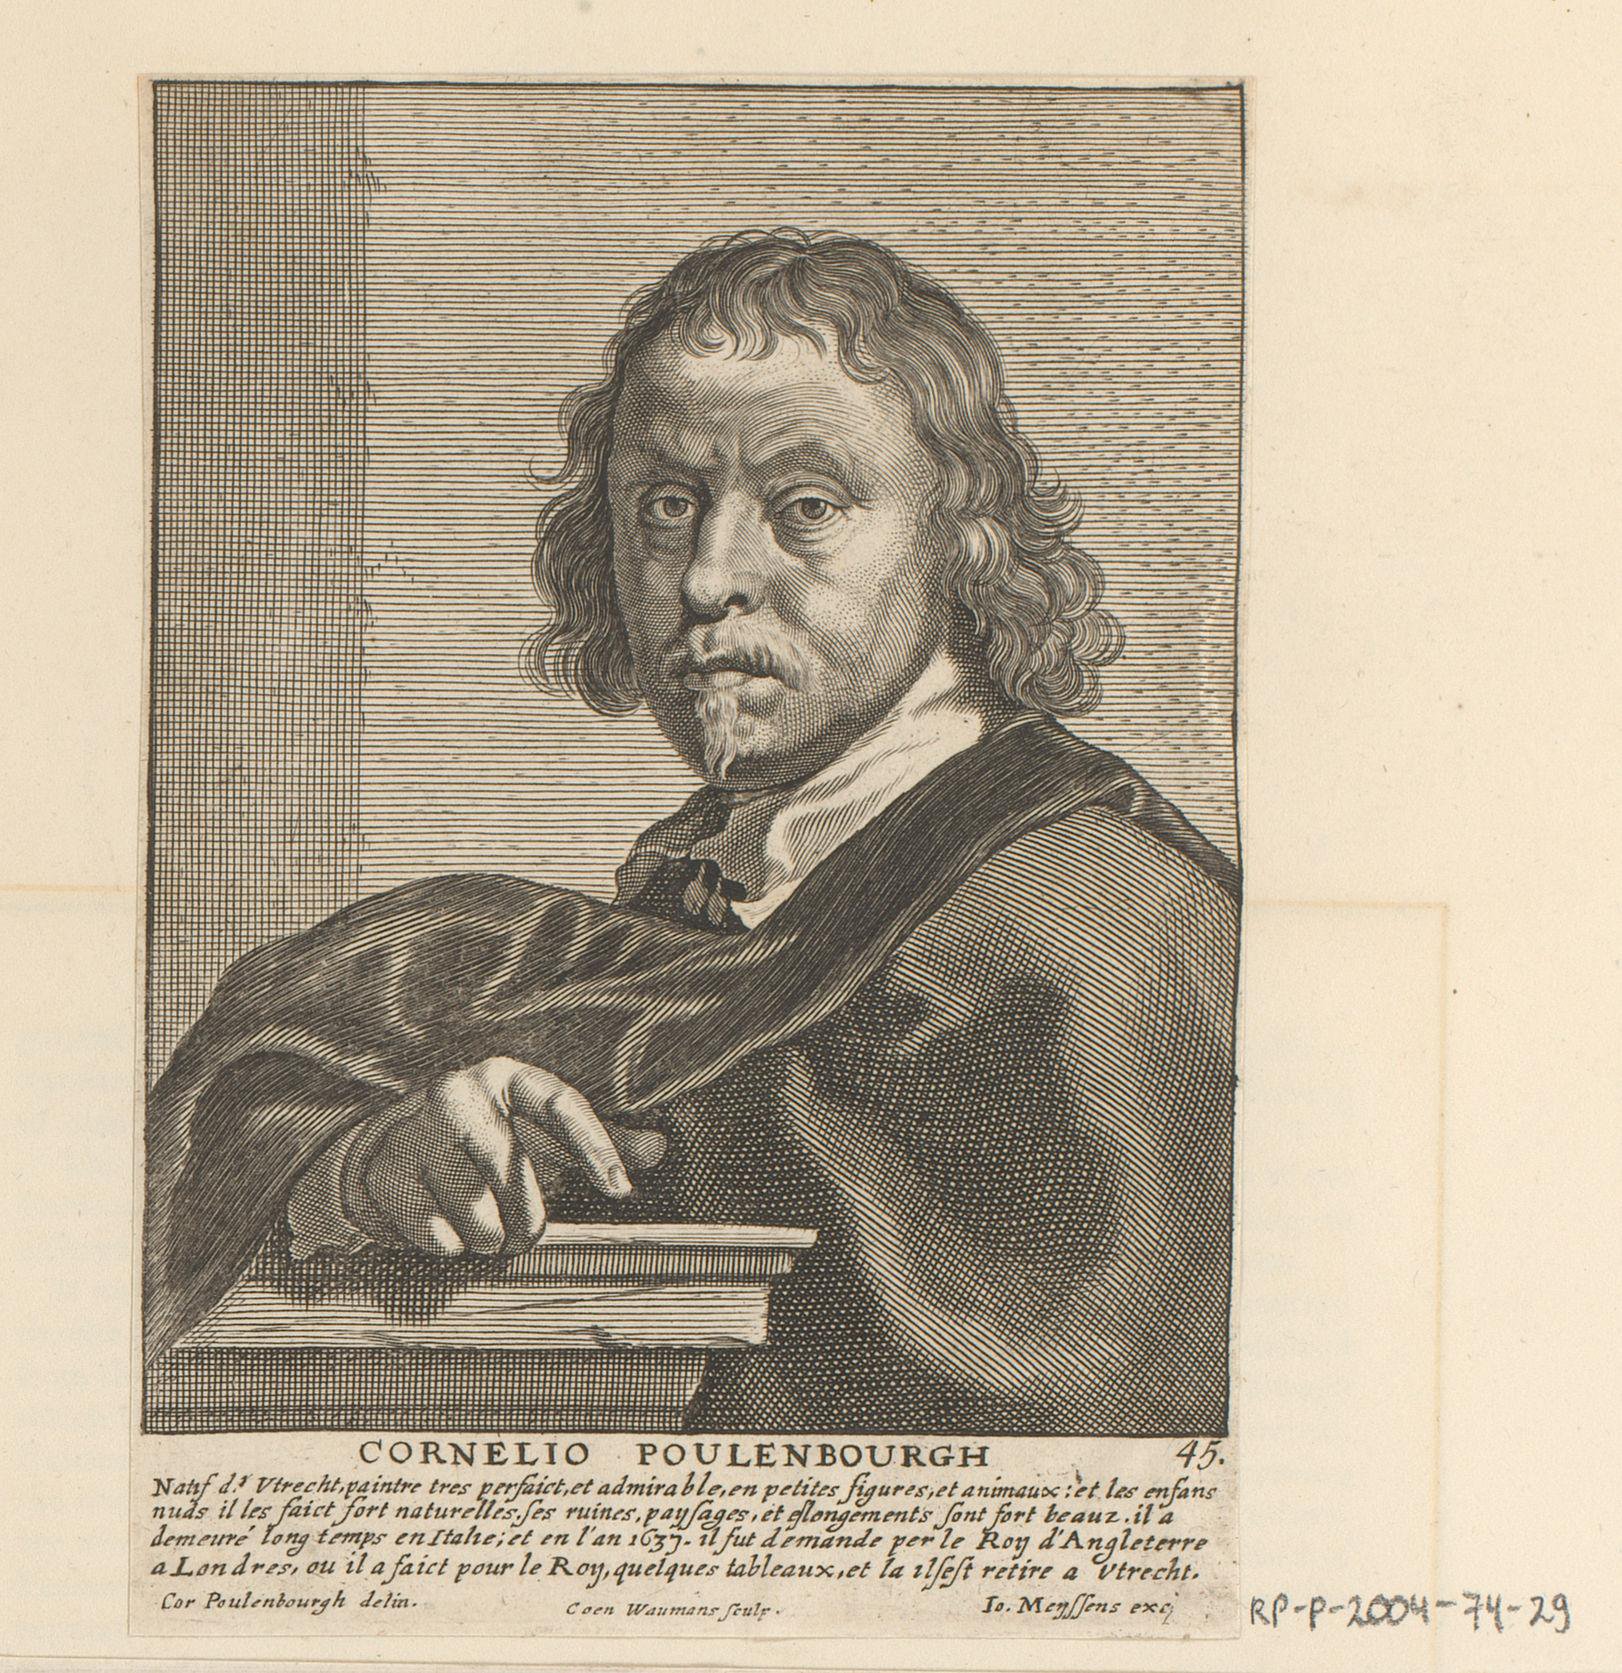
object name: print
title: Cornelio Poulenbourgh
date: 1649-1662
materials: paper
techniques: engraving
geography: antwerp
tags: utrecht, painter, draughtsman, cornelis van poelenburch, historical persons, portrait, self-portrait of painter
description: Prent mogelijk uit: Meyssens, Joannes. Image de divers hommes desprit sublime qui par leur art et science deburovent vivre eternellement et des quels la louange et renommée faict estonner le monde. 2 dln. Antwerpen: Joannes Meyssens, 1649, dl. I, p. 33. Andere staat van prent gebruikt in: Bie, Cornelis De. Het gulden Cabinet vande edel vry schilder const, inhoudende den lof vande vermarste schilders, architecte, beldthowers ende plaetsnyders van dese eeuw. Antwerpen: Joannes Meyssens, 1662 [1661 foutief op titelpagina], p. 257. De samensteller heeft deze prent in het album geplakt als illustratie bij: Pilkington, Matthew en Johann Heinrich Füssli. A dictionary of painters, from the revival of the art to the present period. 4 dln. Londen: John Crowder, 1805, dl. 3, p. 404.